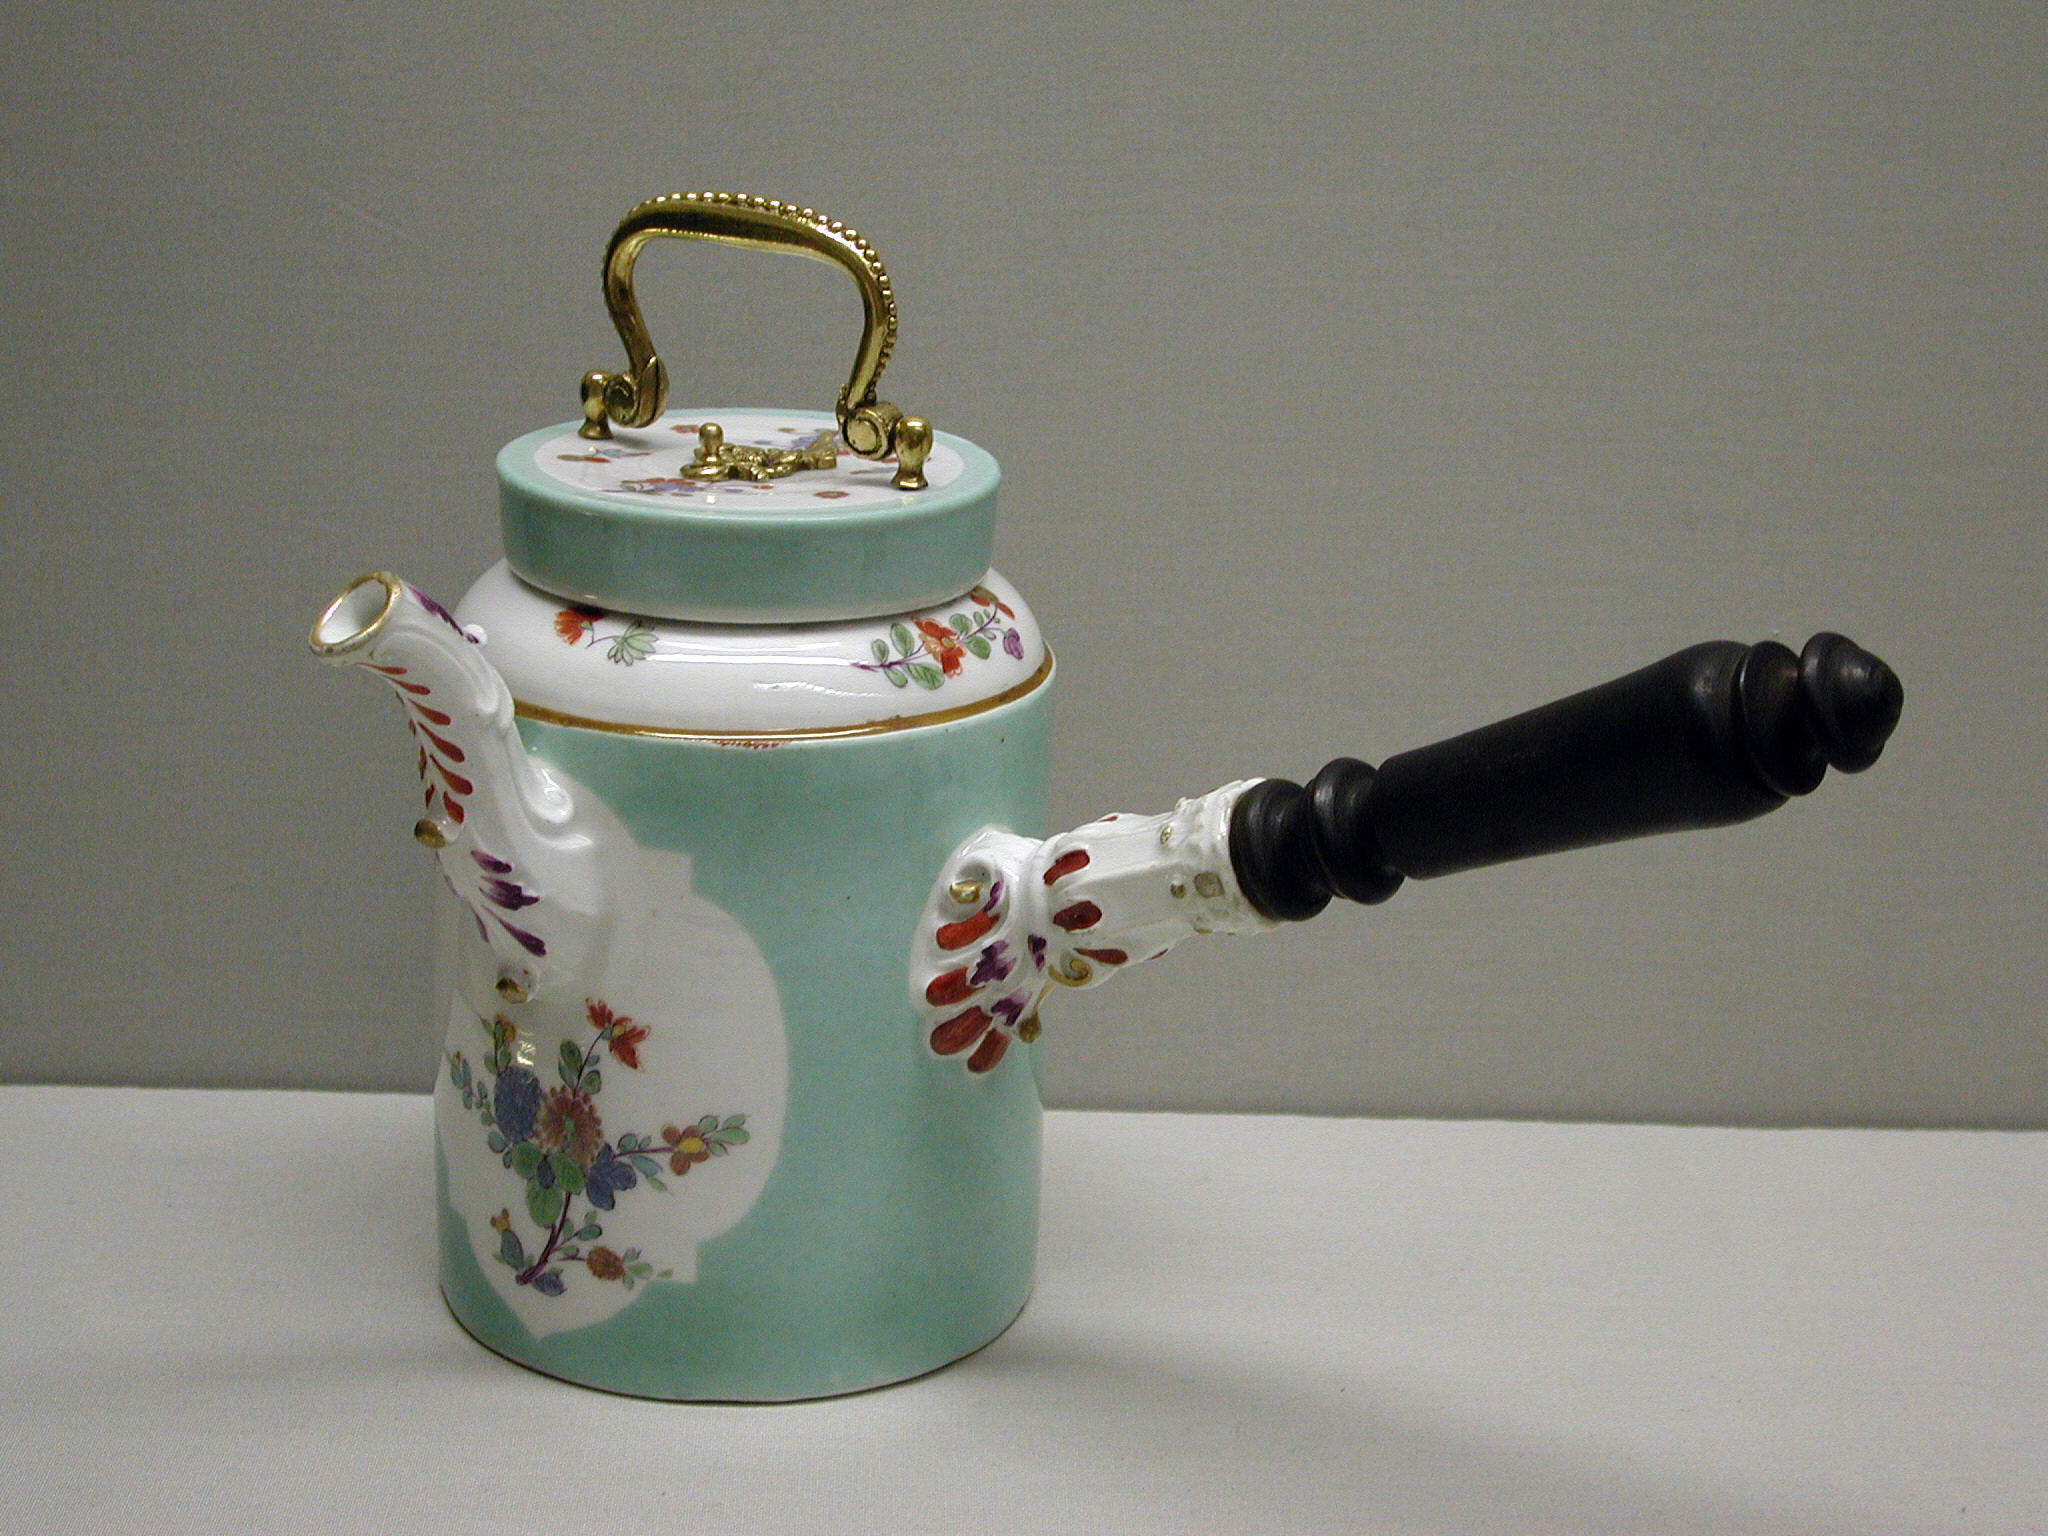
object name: chocolate pot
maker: meissen manufactory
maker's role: manufactory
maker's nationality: german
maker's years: 1710-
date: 1735-1740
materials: gilt bronze, hard paste porcelain, wood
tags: flowers